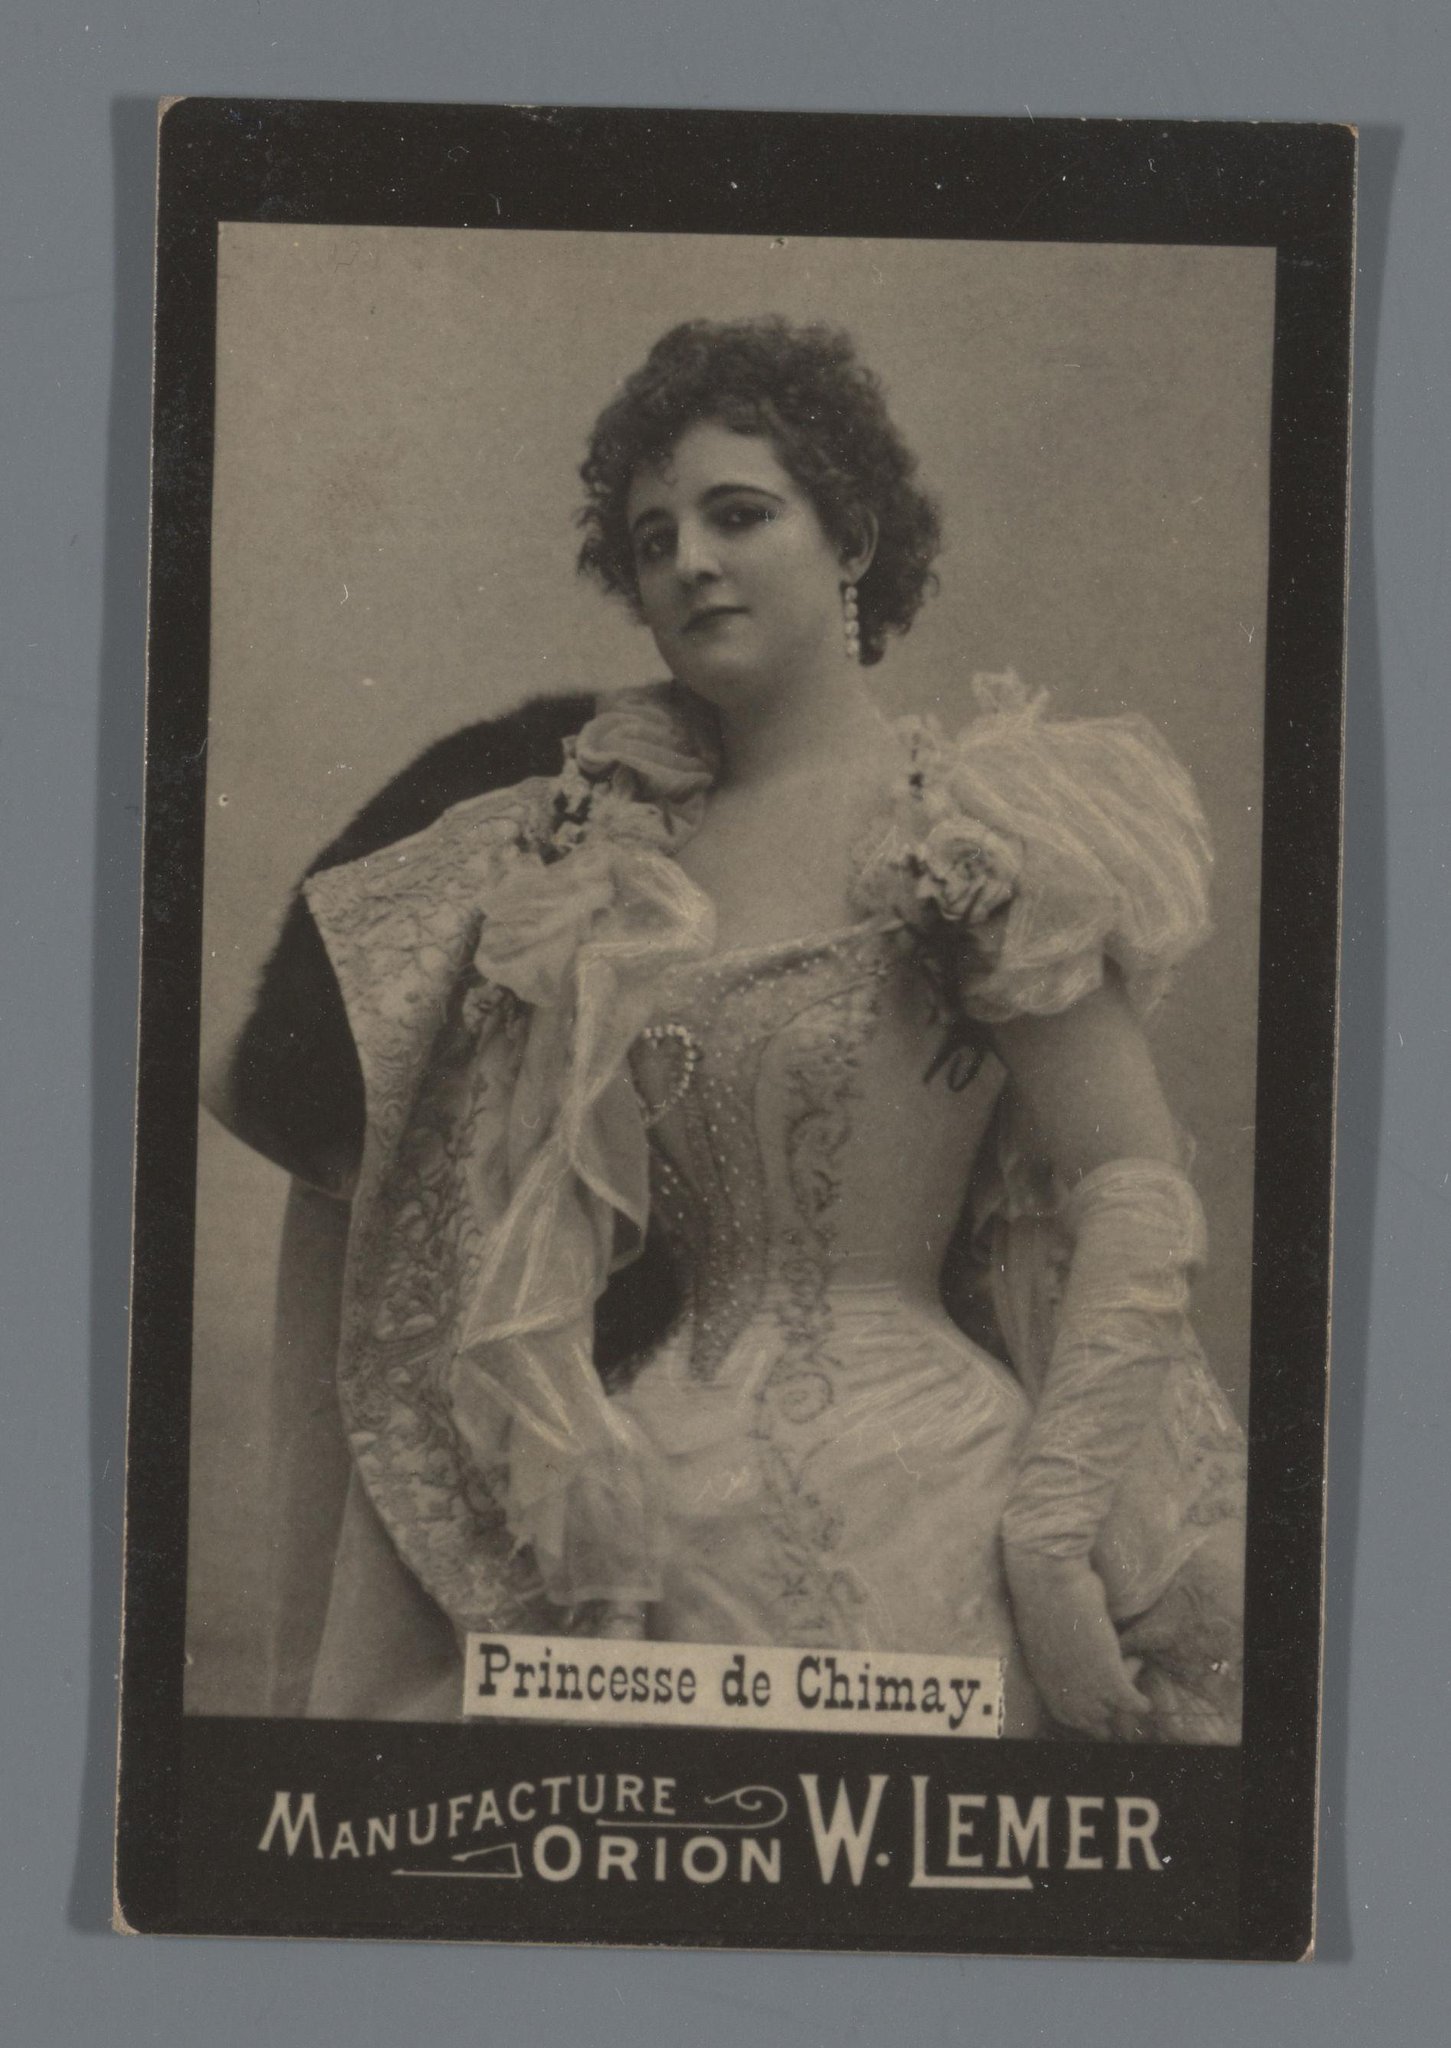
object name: photograph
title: Princesse de Chimay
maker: Anonymous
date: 1890-1900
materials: photographic support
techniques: gelatin silver print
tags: historical persons - bb - woman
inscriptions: inscription: ‘MANUFACTURE/ ORION W. LEMER’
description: Dergelijke foto's stonden bekend als 'zwartjes'. Men verkreeg ze bij aanschaf van bepaalde merken thee, cacao, sigaretten, beschuit, etc. om te verzamelen. Er waren speciaal voor de 'zwartjes' vervaardigde verzamelalbums in omloop.